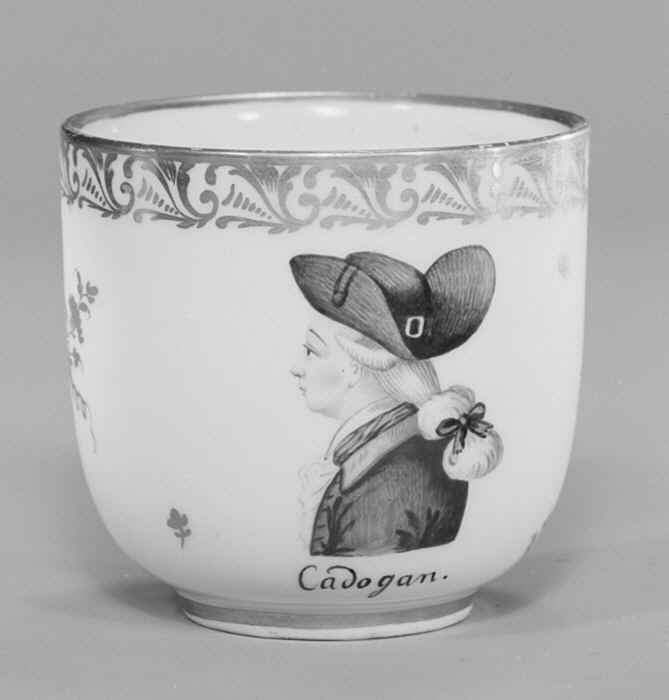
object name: cup and saucer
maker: imperial porcelain manufactory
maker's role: manufactory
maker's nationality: austrian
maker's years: 1744-1864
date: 1770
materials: hard paste porcelain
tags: men,profiles